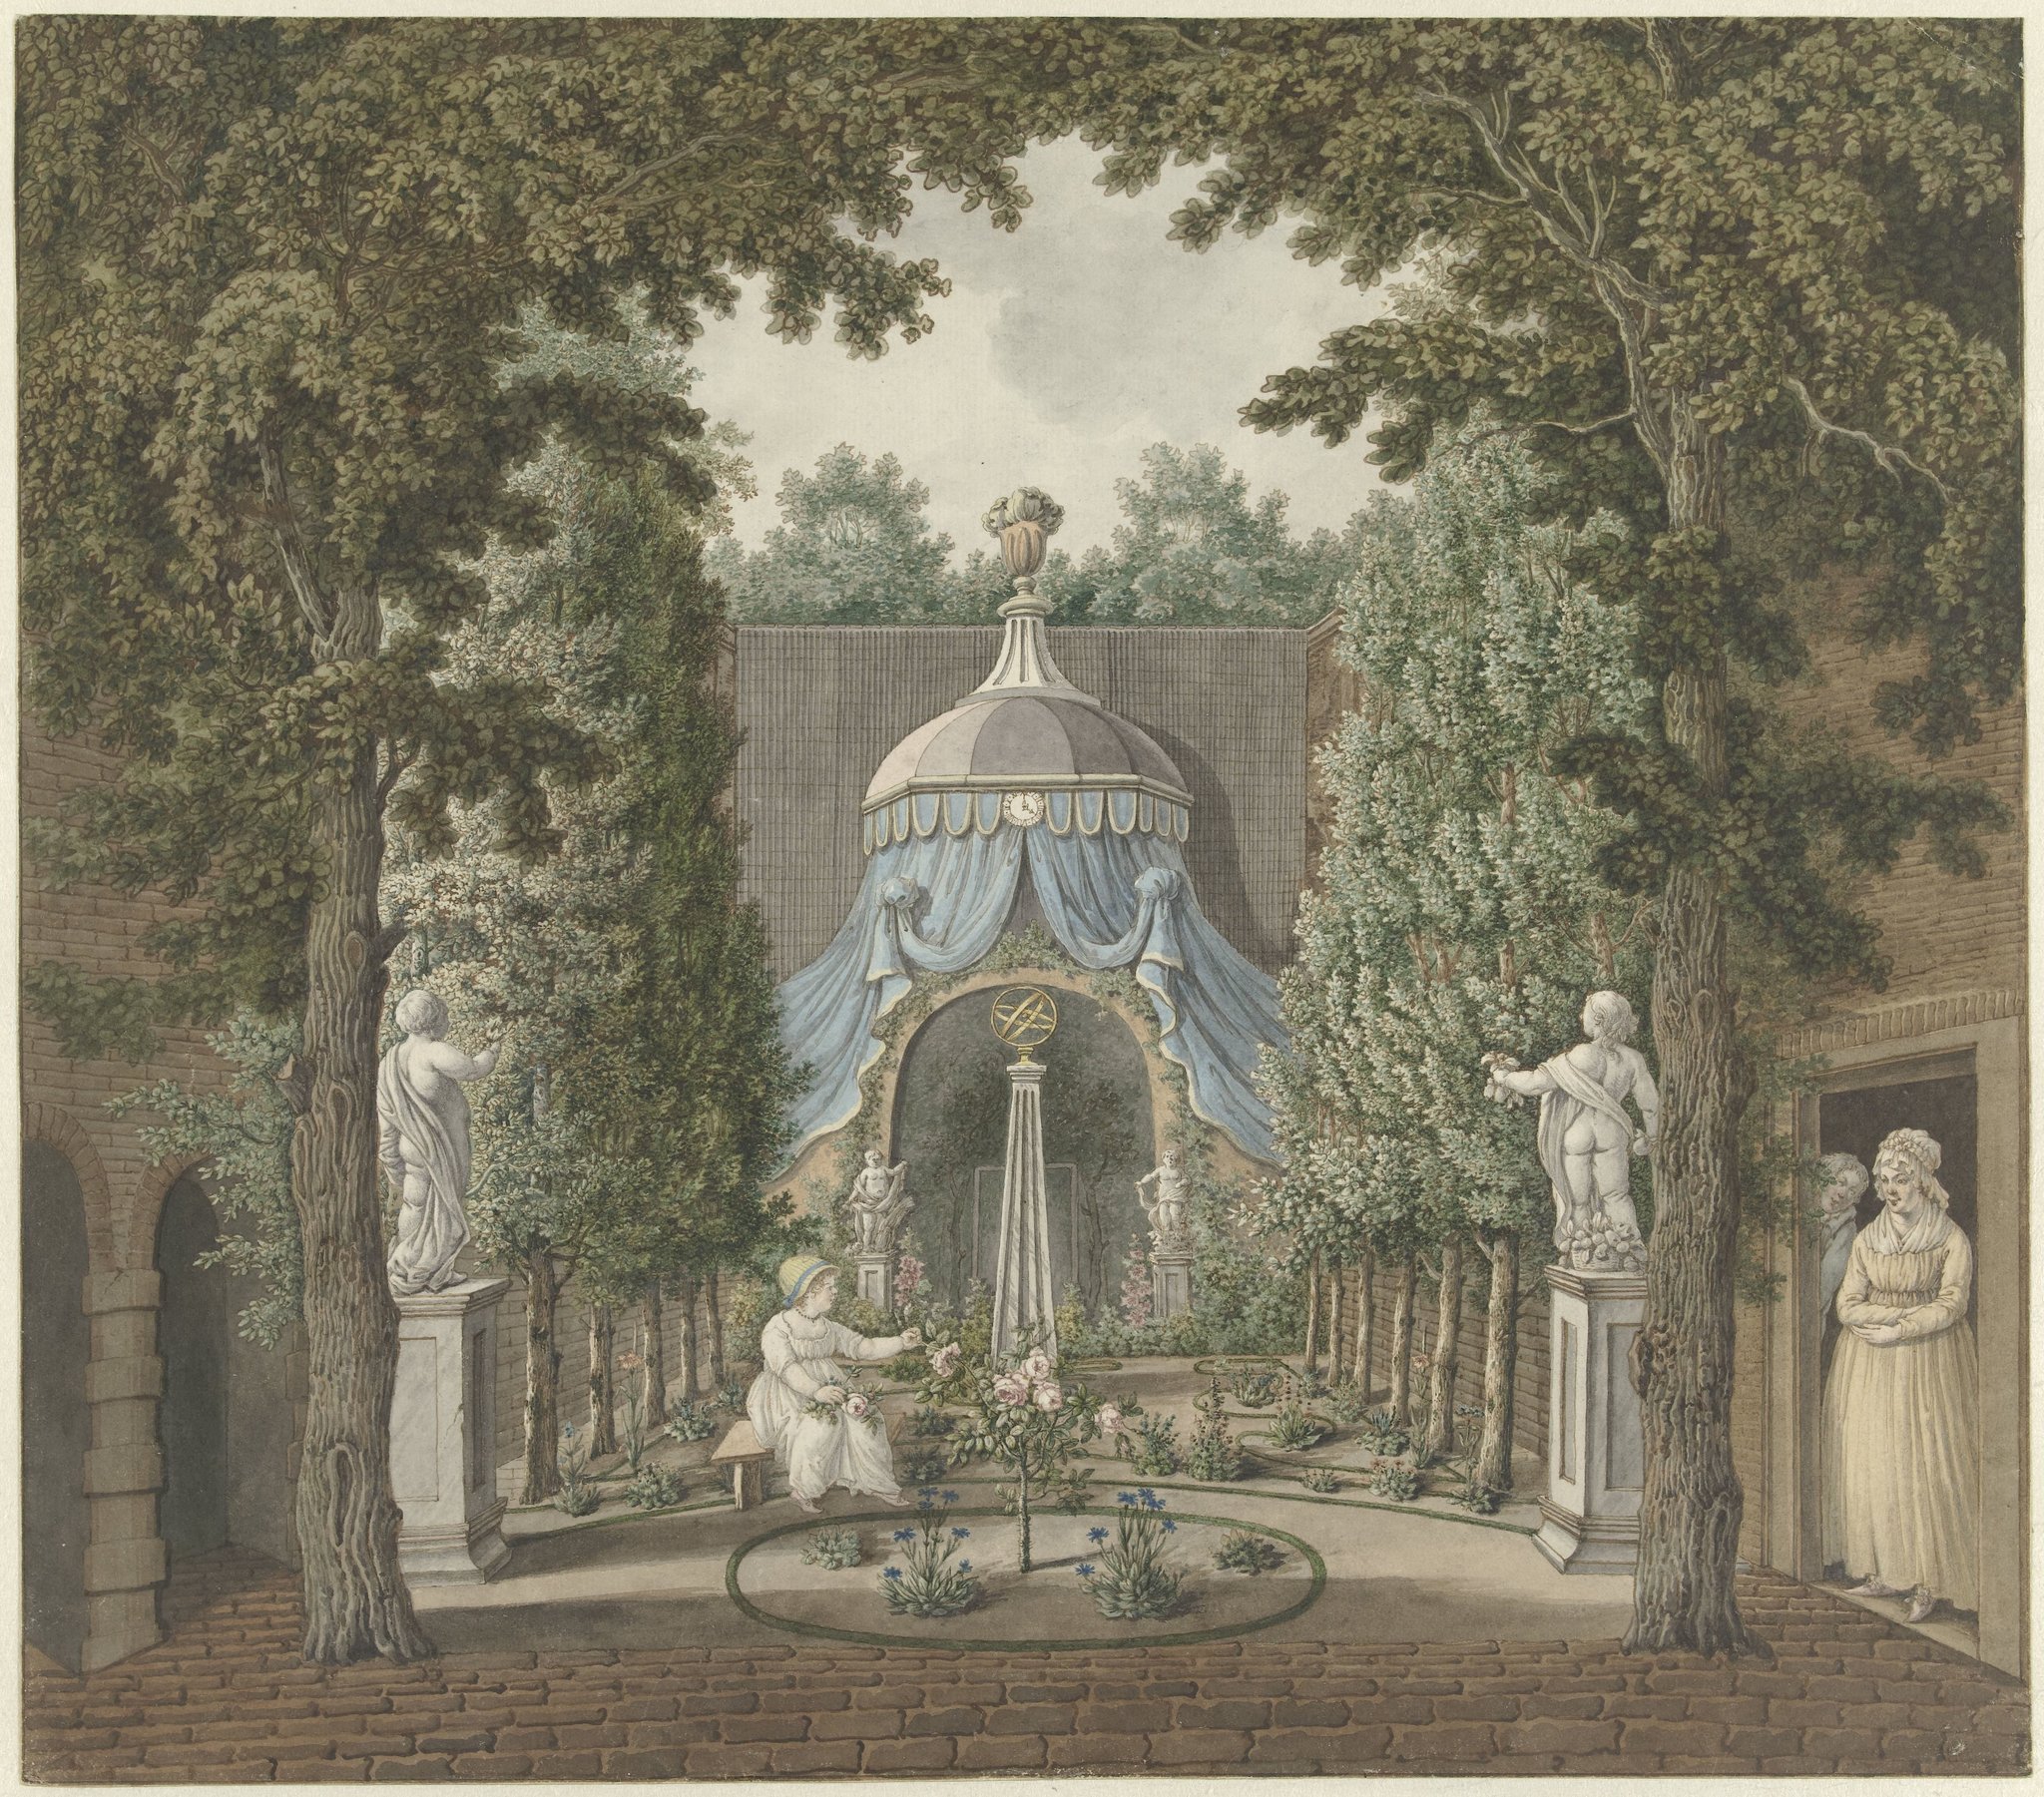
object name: drawing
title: Theatre Scene in a City Garden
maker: barend hendrik thier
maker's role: draughtsman, print maker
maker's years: 1743-1811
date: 1753-1811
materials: ink, paper, watercolor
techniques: brush, pen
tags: group of actors, troupe; actors on the stage